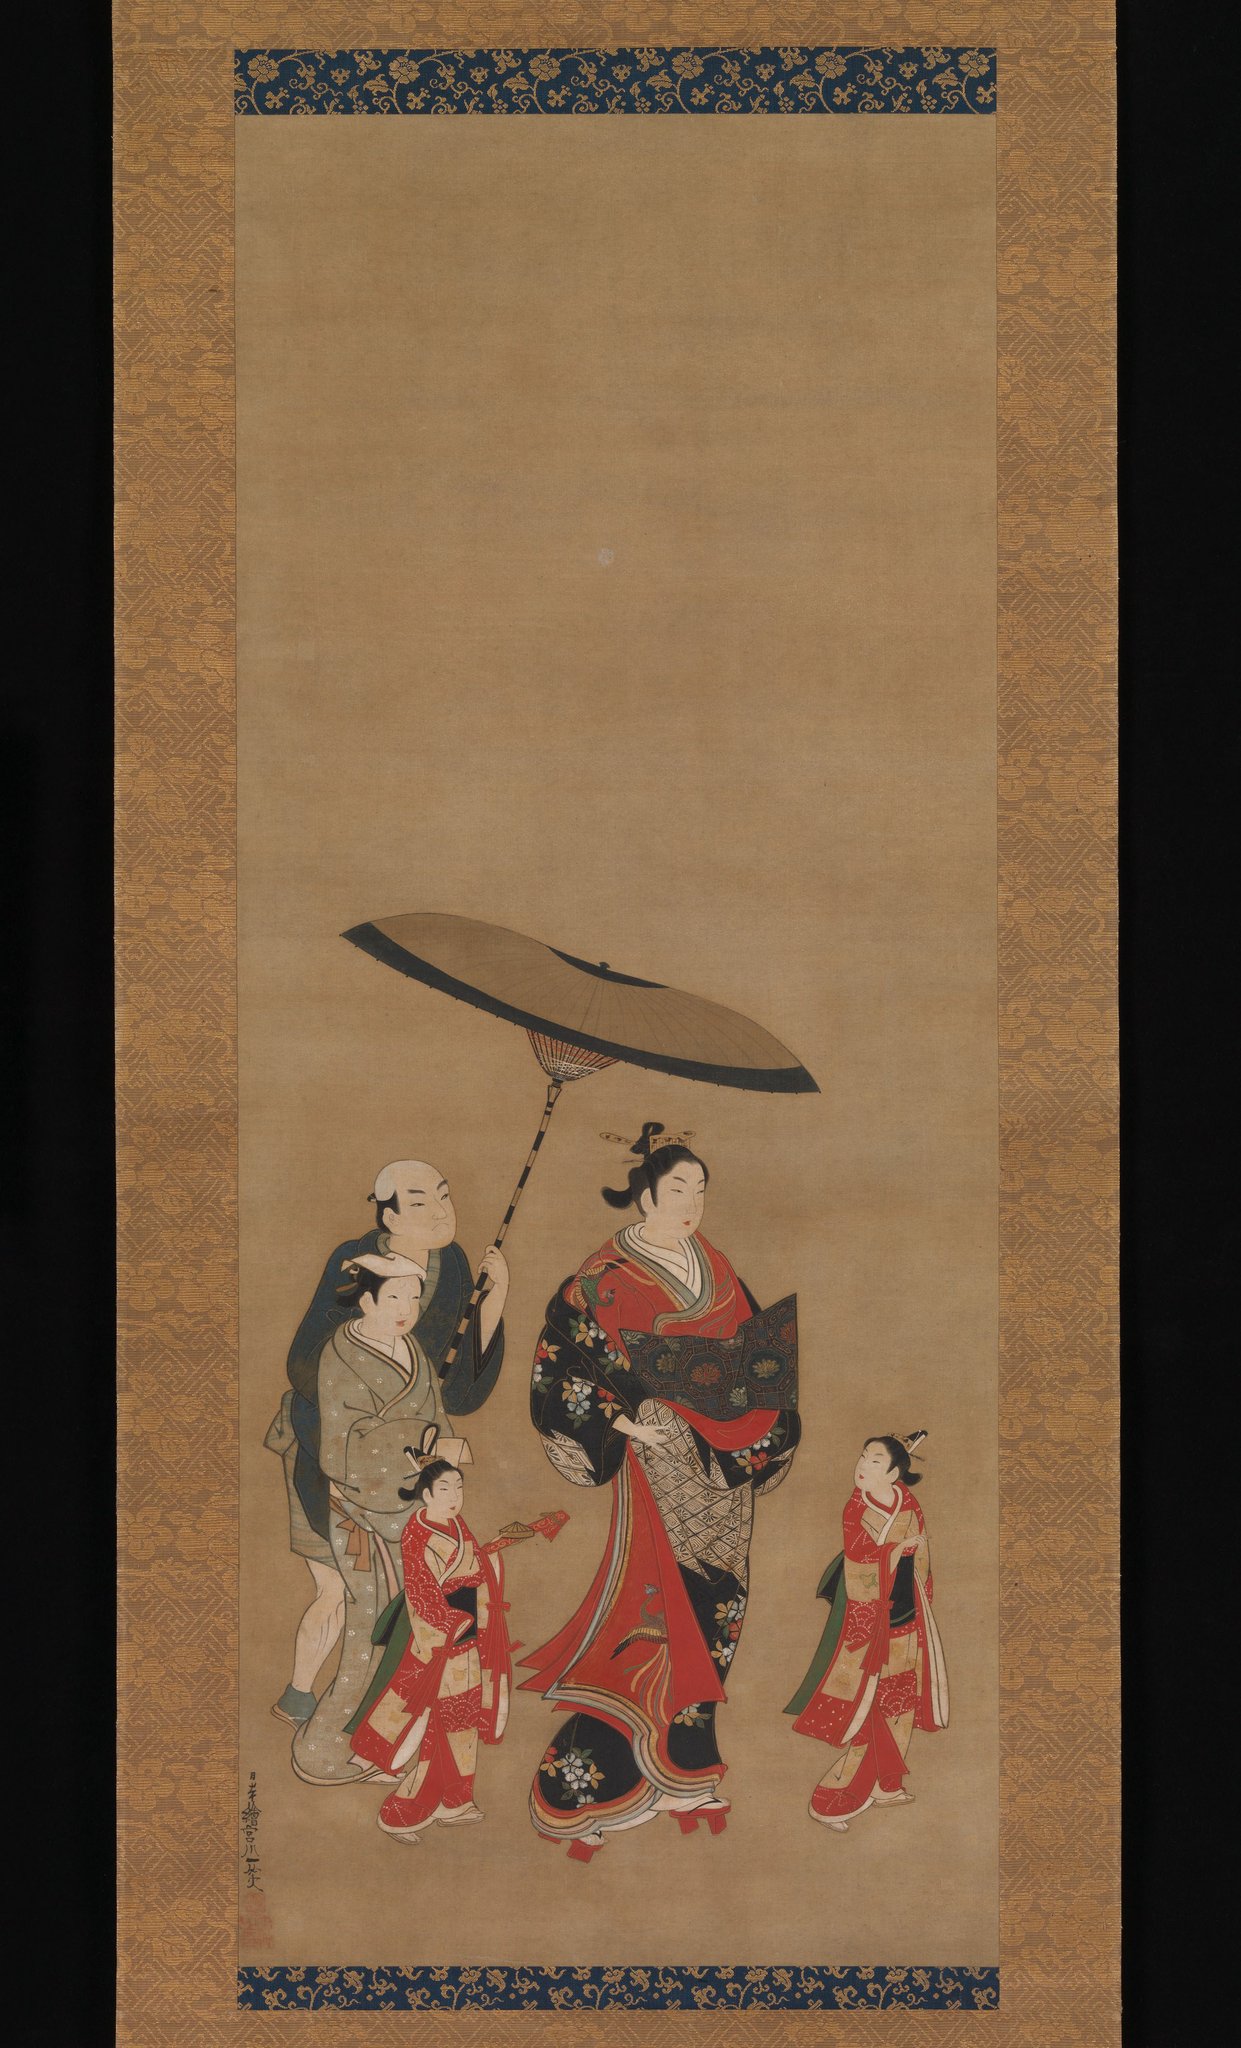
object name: hanging scroll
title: Courtesan on Parade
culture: japanese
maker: miyagawa isshō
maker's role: artist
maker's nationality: japanese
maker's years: 1689-1780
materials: gold, ink, silk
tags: girls,men,women,parasols